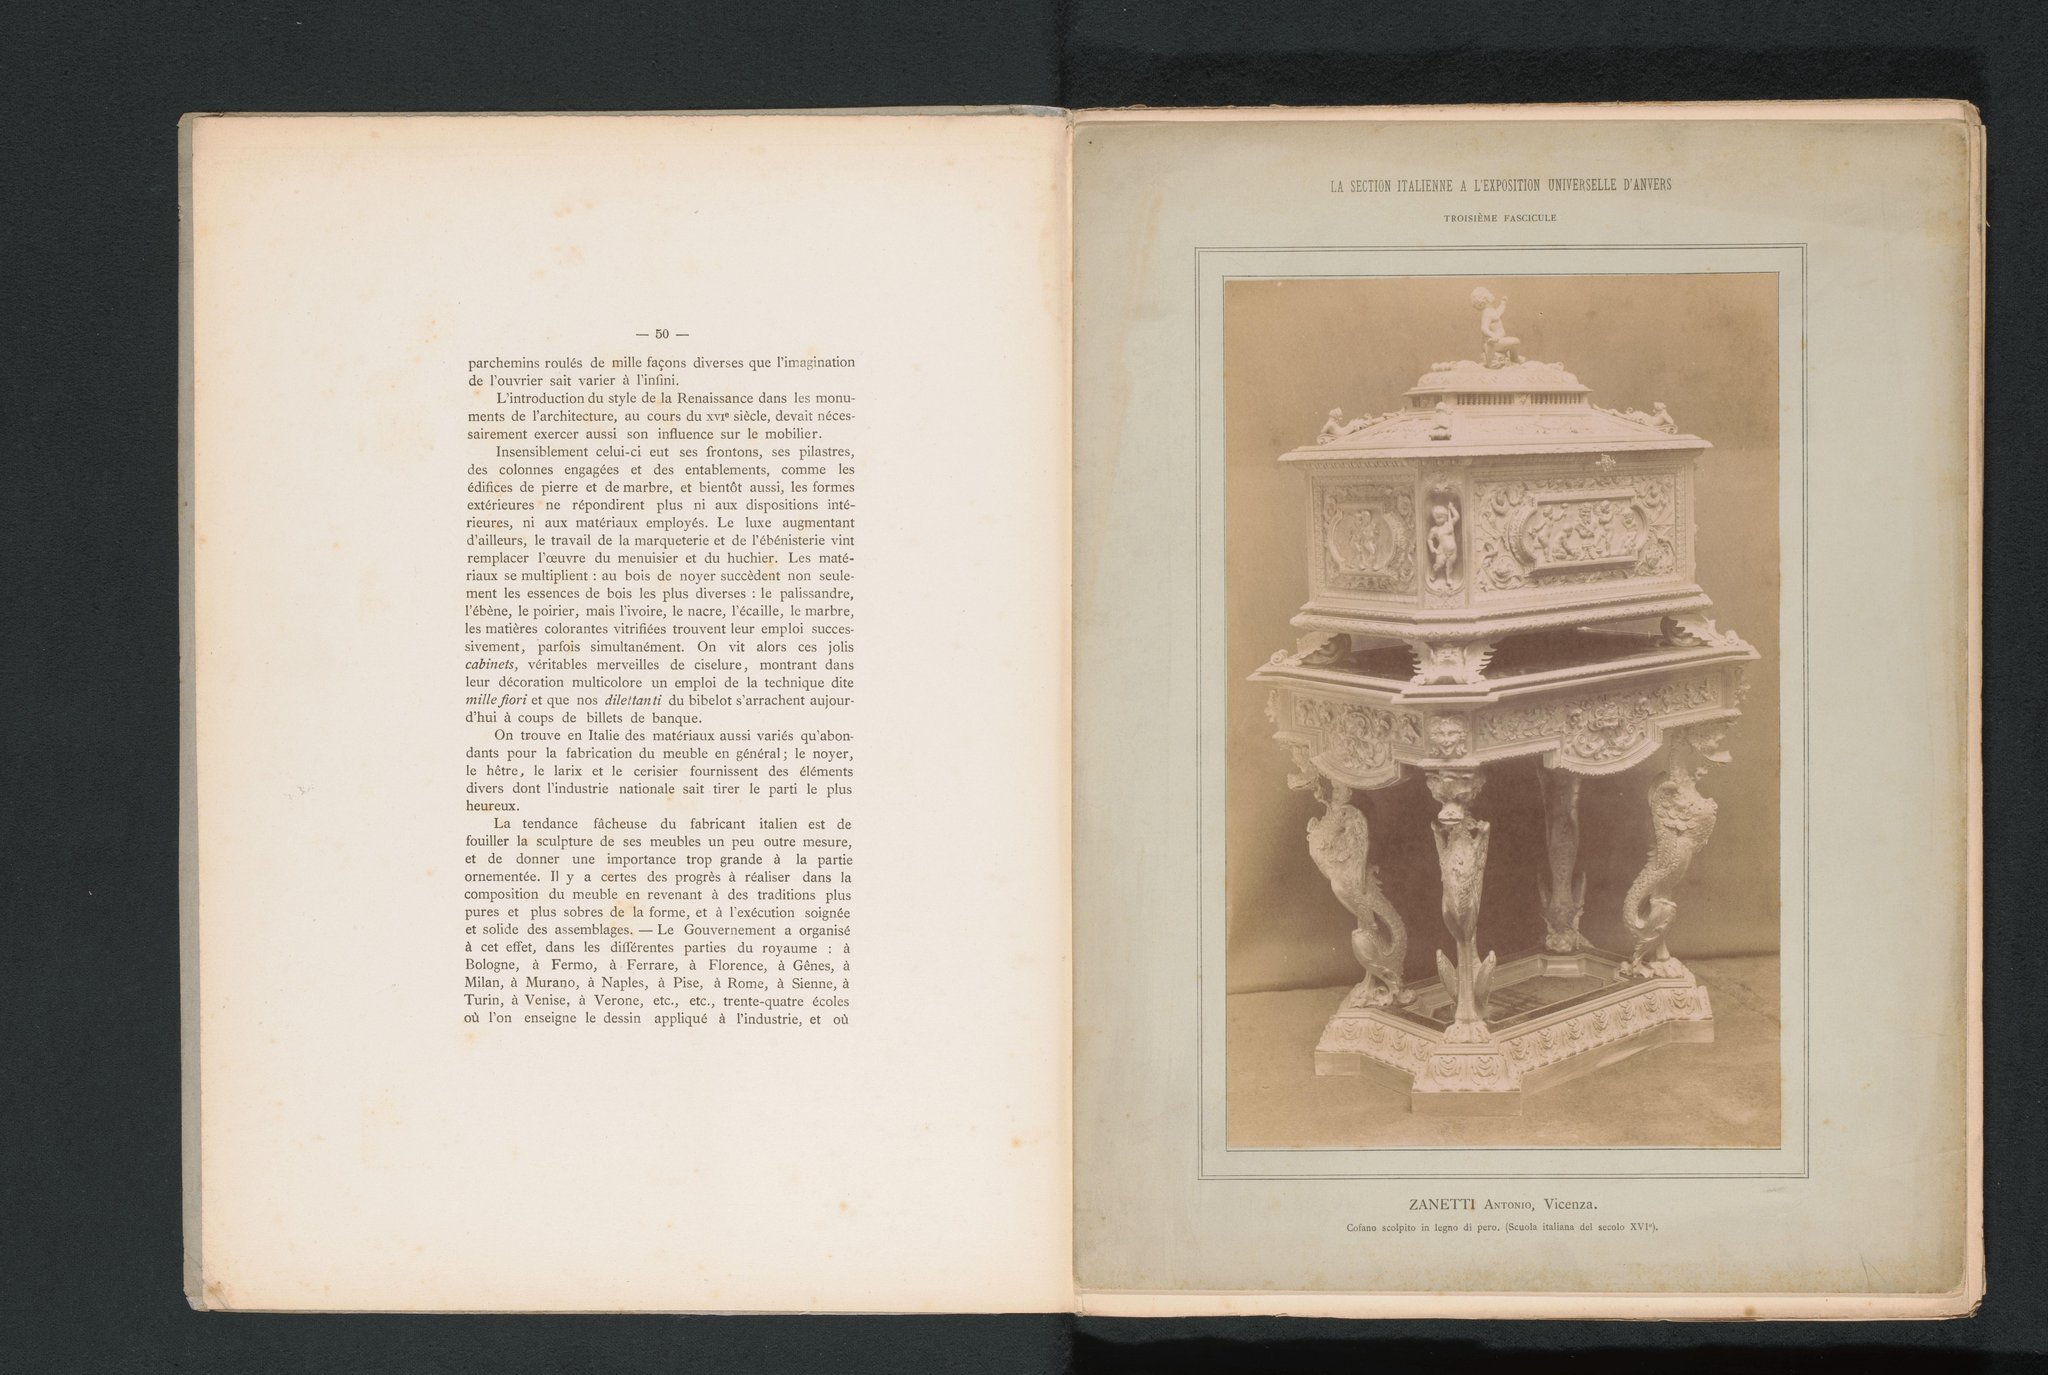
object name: page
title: Kist van perenhout op een voetstuk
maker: Anonymous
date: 1880-1885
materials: photographic support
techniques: albumen print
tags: chest, coffer (+ wood and other phytogenic material)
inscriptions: inscription: ‘Cofano scolpito in legno di pero. (Scuola italiana del secolo XVIe).’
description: Foto op losse plaat tegenover pagina 50.